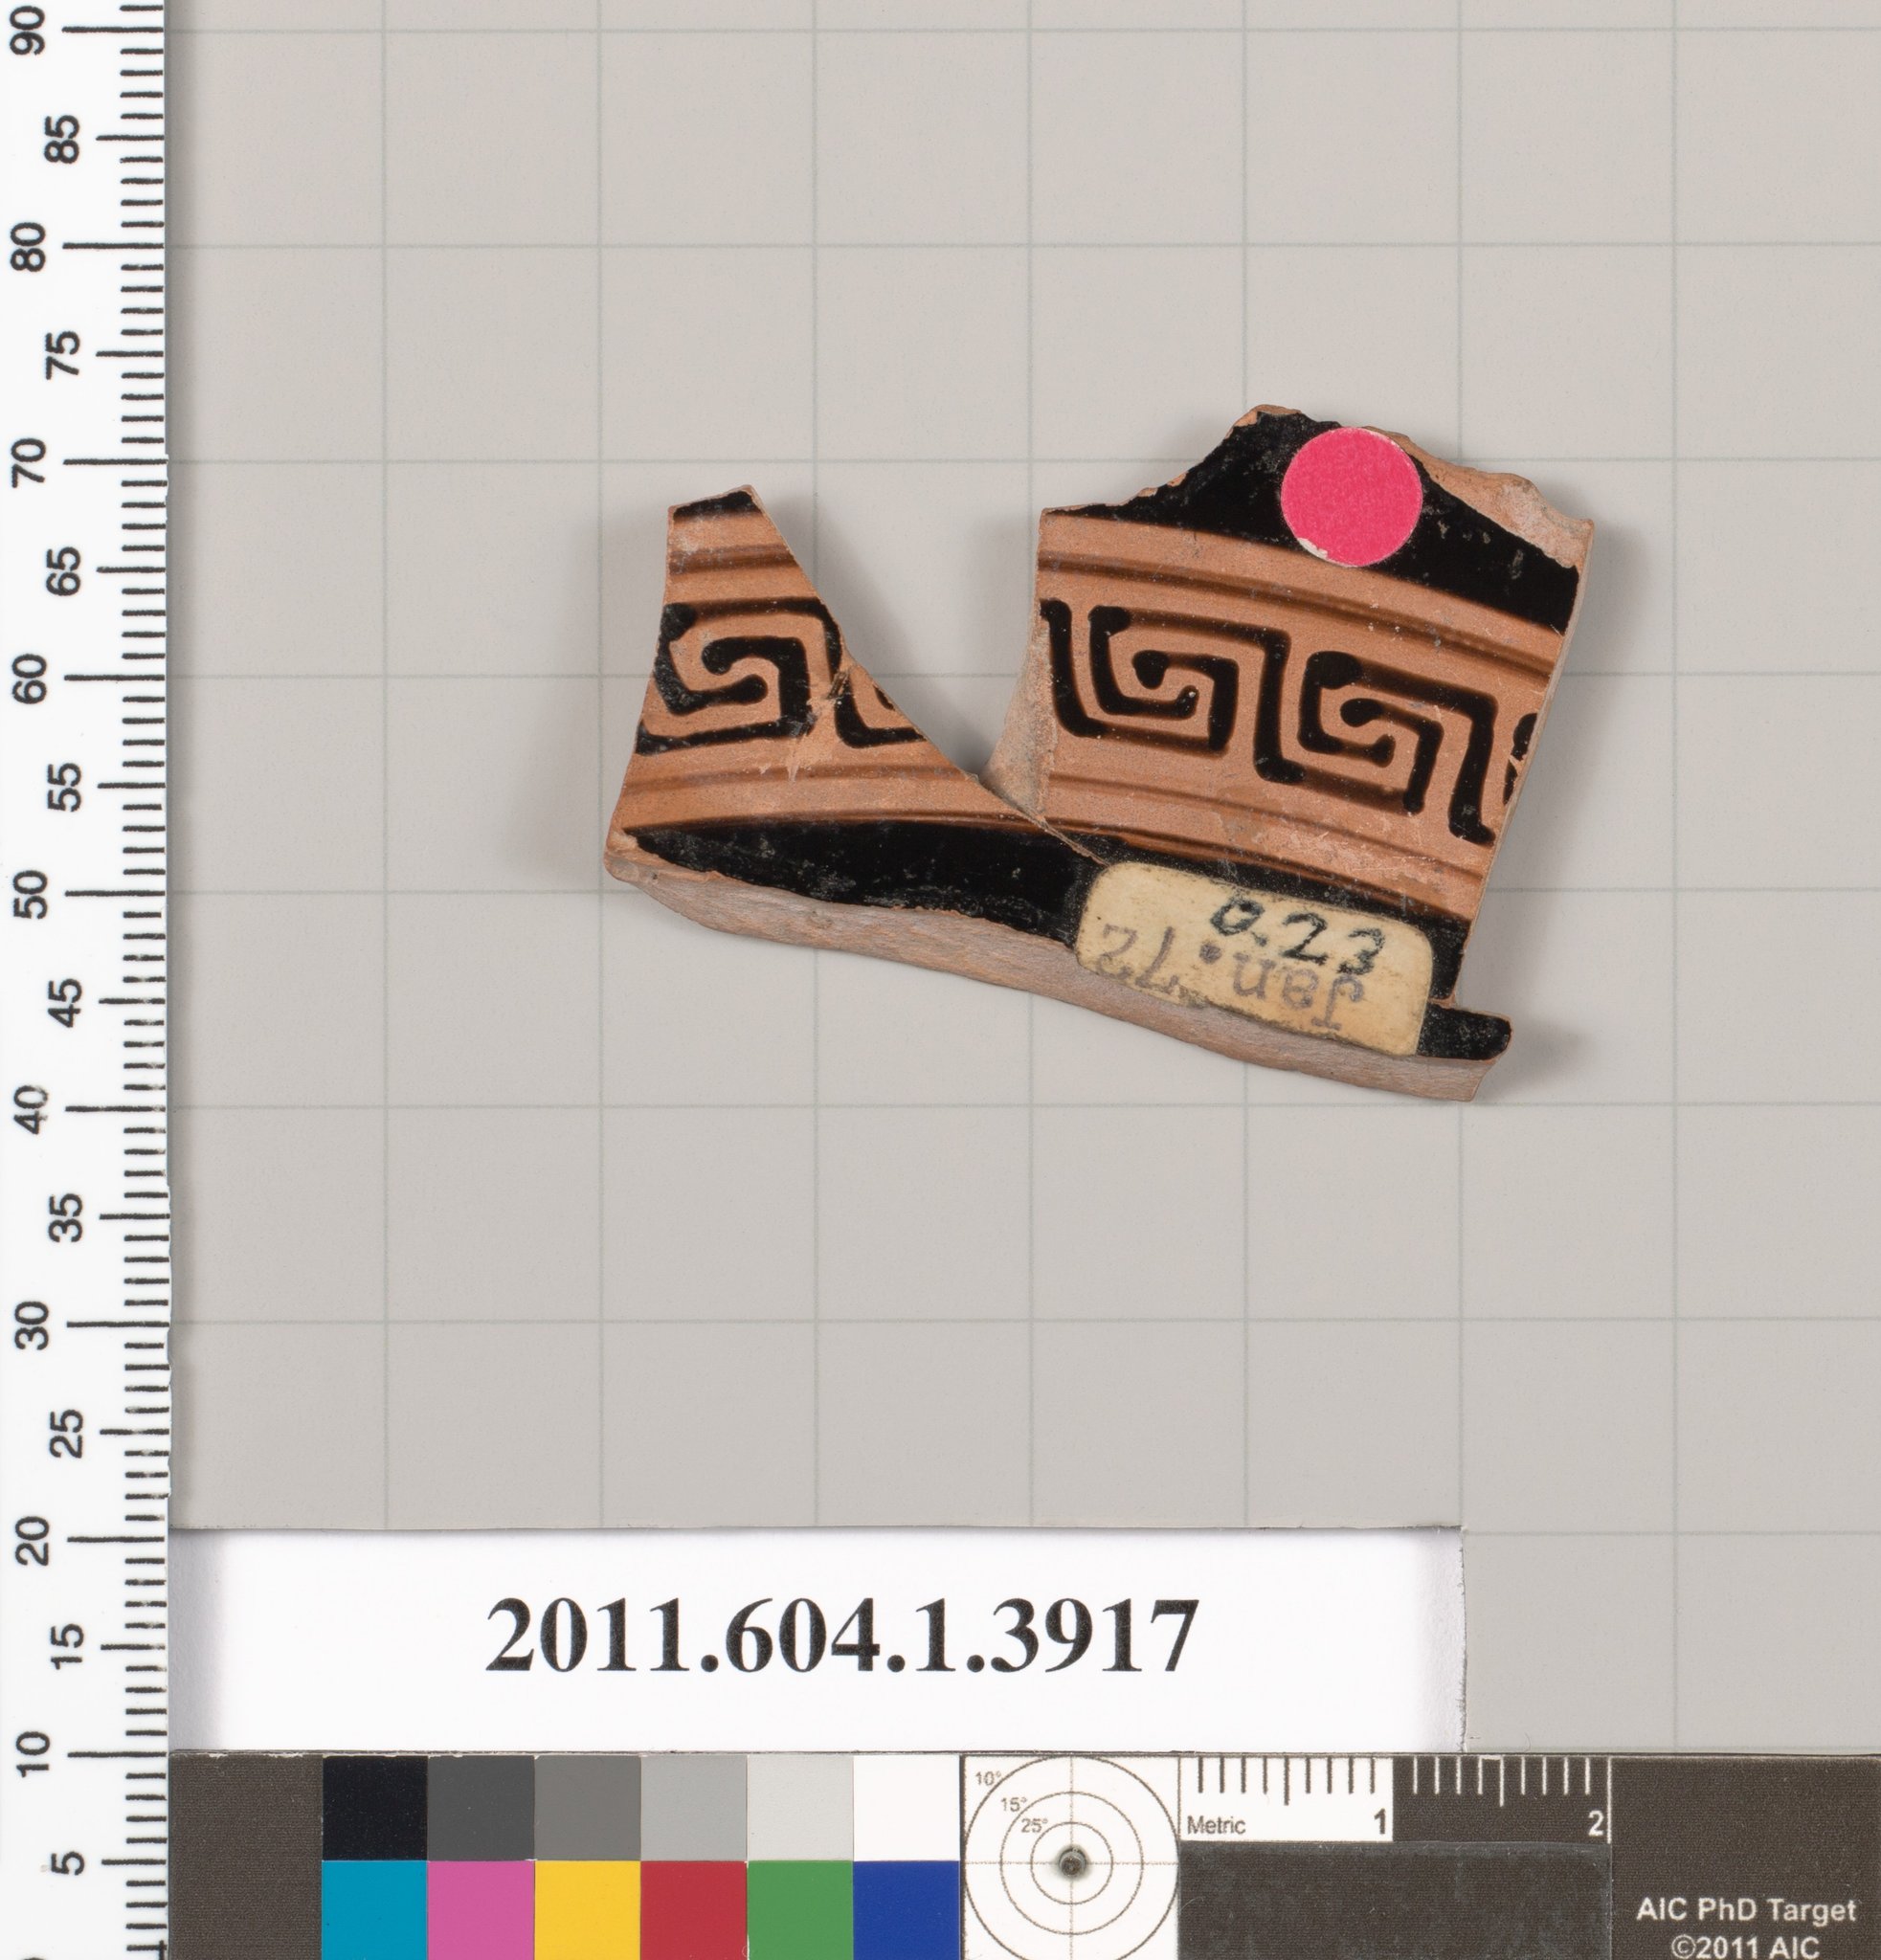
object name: kylix fragment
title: Terracotta fragment of a kylix (drinking cup)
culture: greek, attic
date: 475-451 BCE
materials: terracotta